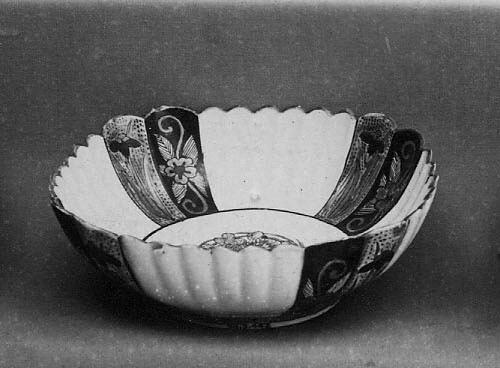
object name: dish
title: Vegetable Dish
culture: japanese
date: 1800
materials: enamel, porcelain